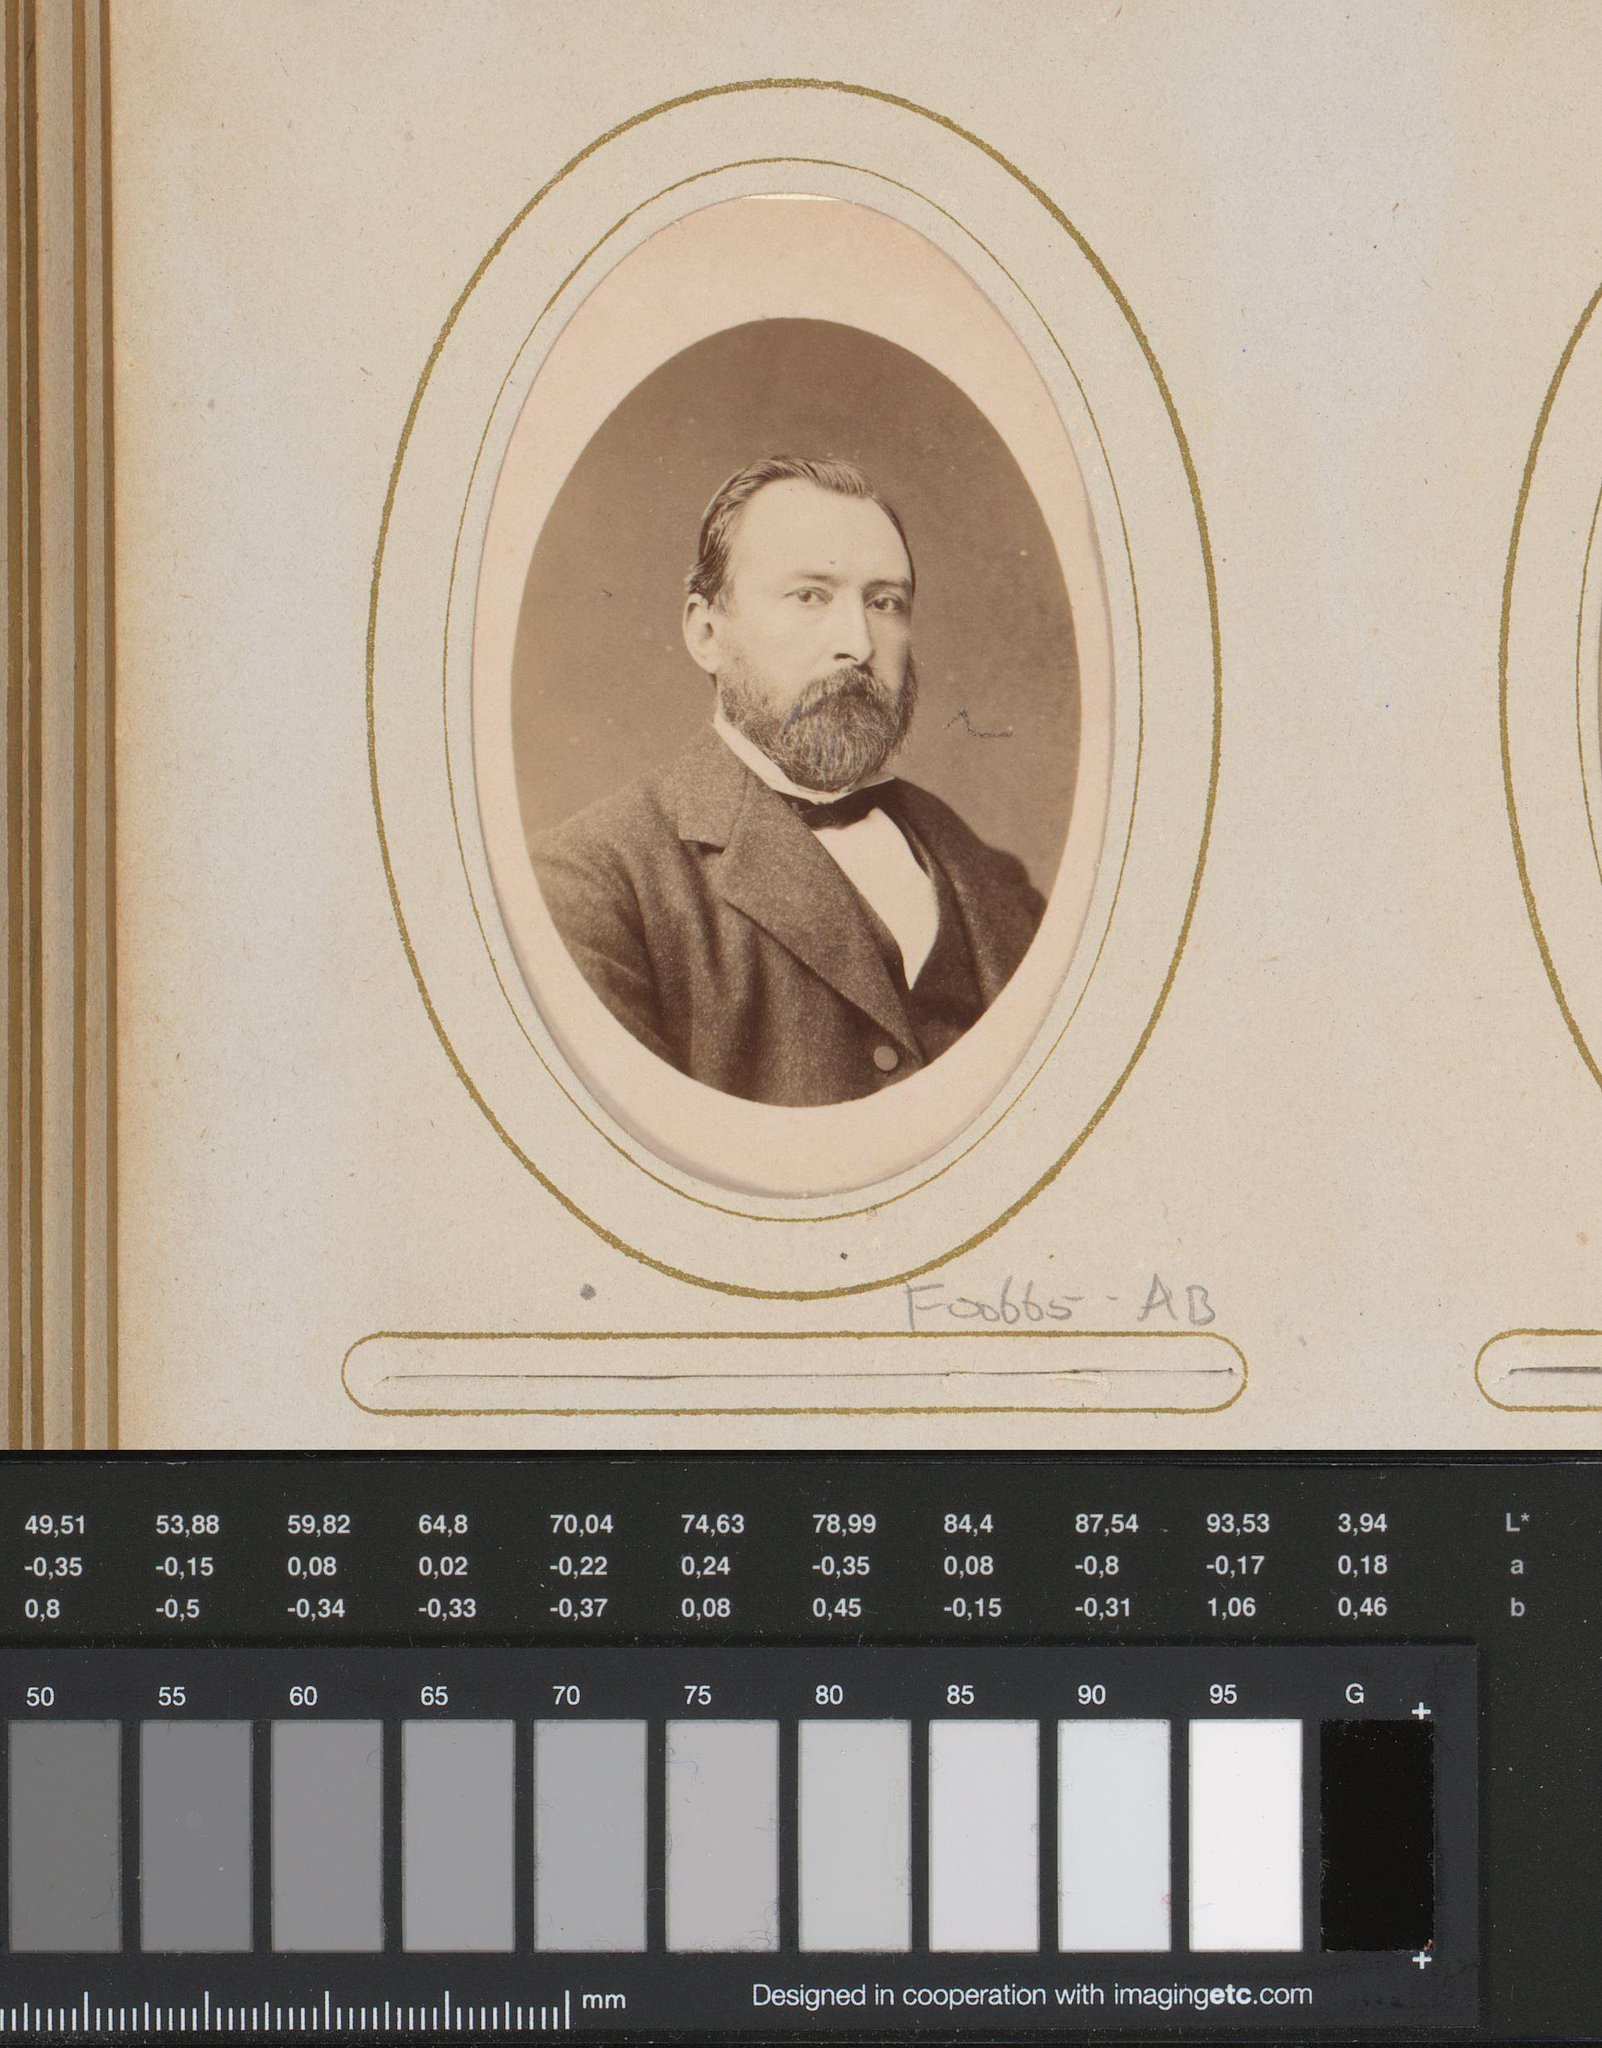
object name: album leaf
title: Portret van een man met baard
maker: idanus hendrikus slaterus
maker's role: fotograaf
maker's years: 1846-1921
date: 1873-1892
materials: cardboard, photographic support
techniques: albumen print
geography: leeuwarden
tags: historical persons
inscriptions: inscription: ‘Leeuwarden, Weerd G 35, hoek Bagijnestraat’